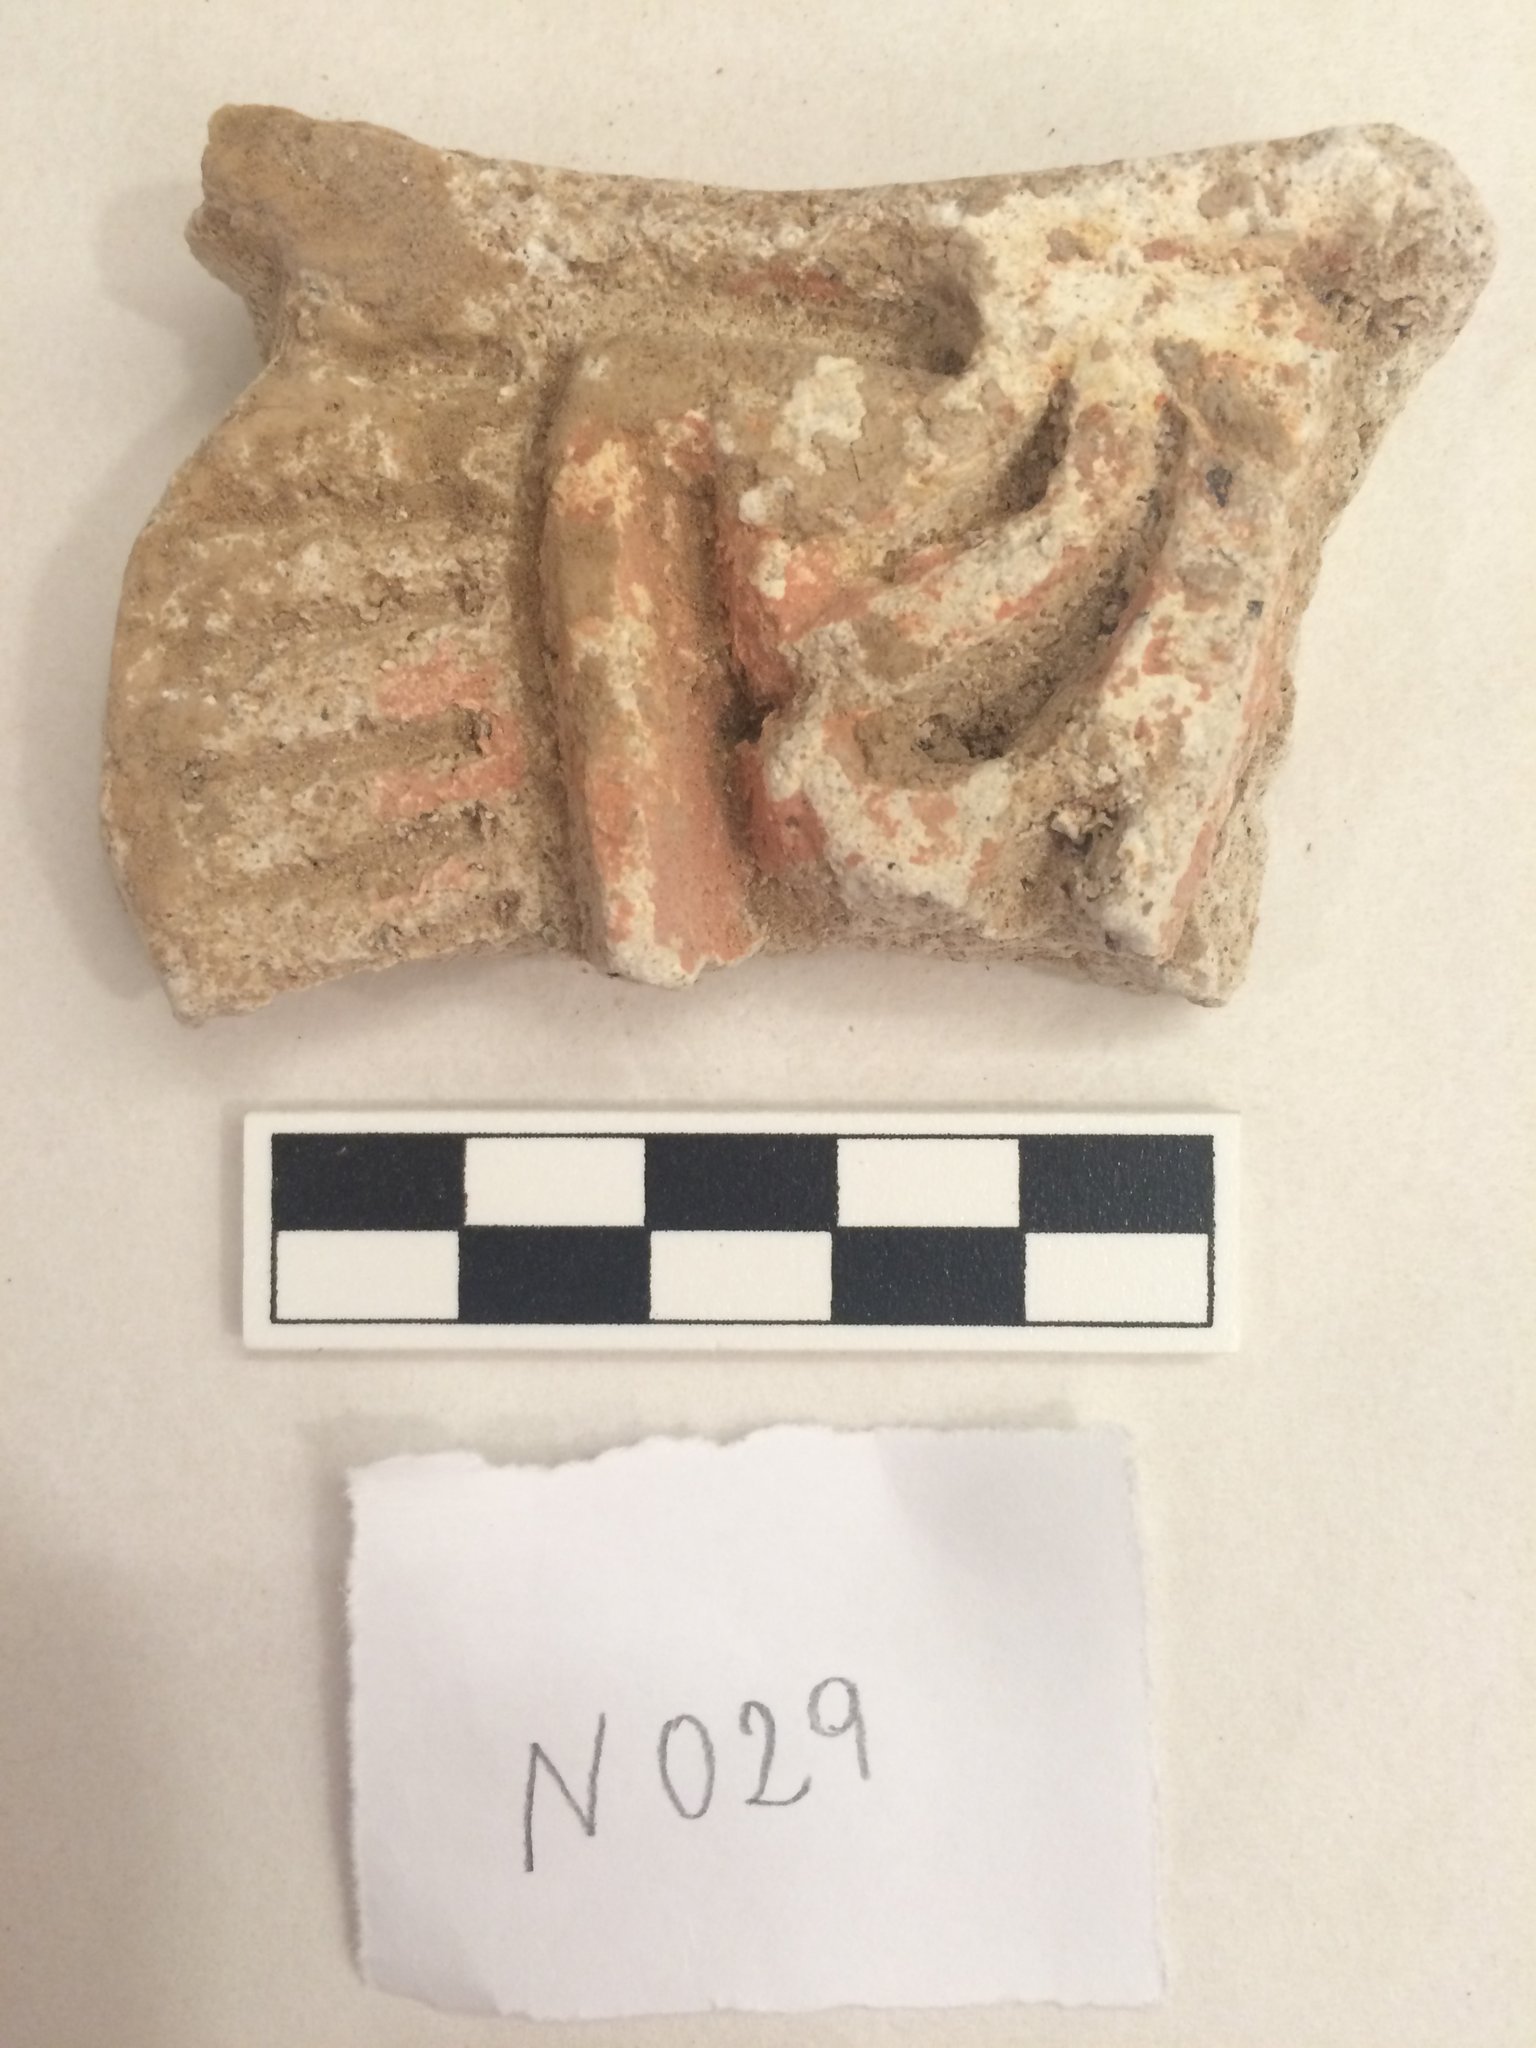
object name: fragment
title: Stucco Fragment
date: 701-1200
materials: plaster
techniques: carving, painting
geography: iran